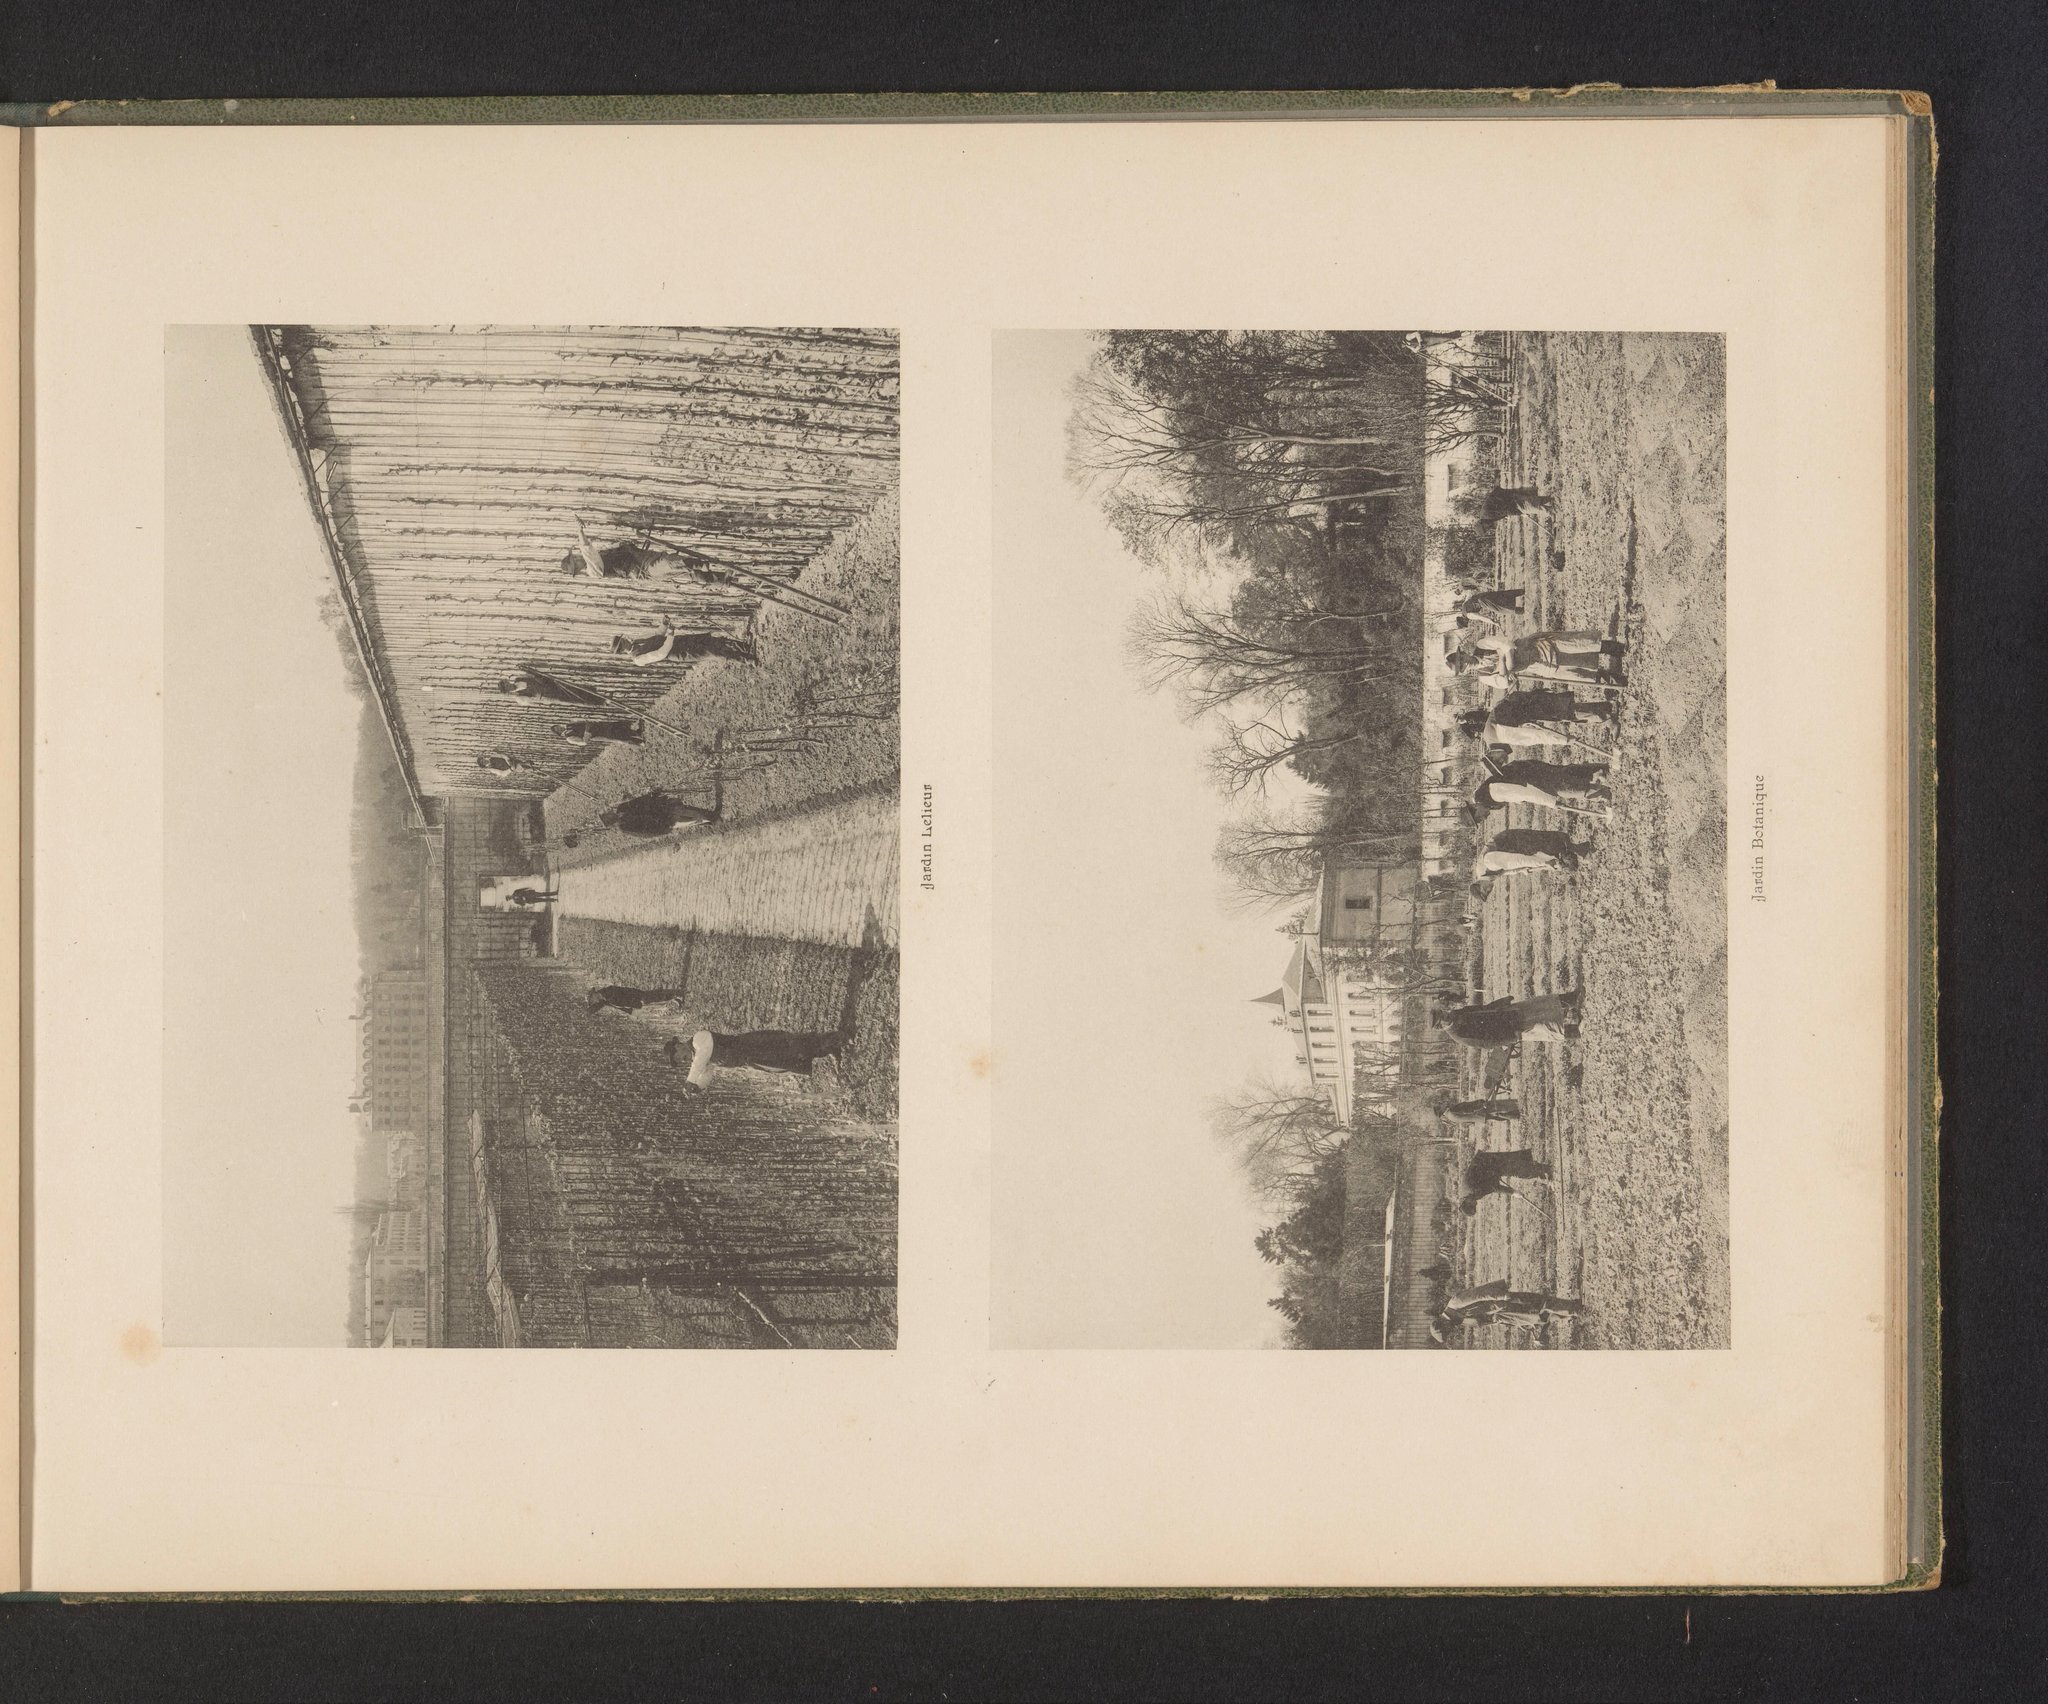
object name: photomechanical print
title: Twee gezichten op tuinen van de École Nationale Superieure d'Horticulture in Versailles, Frankrijk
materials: paper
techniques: photograph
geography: versailles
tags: horticulture, vegetable culture, market gardening, botanic garden, 'hortus botanicus'